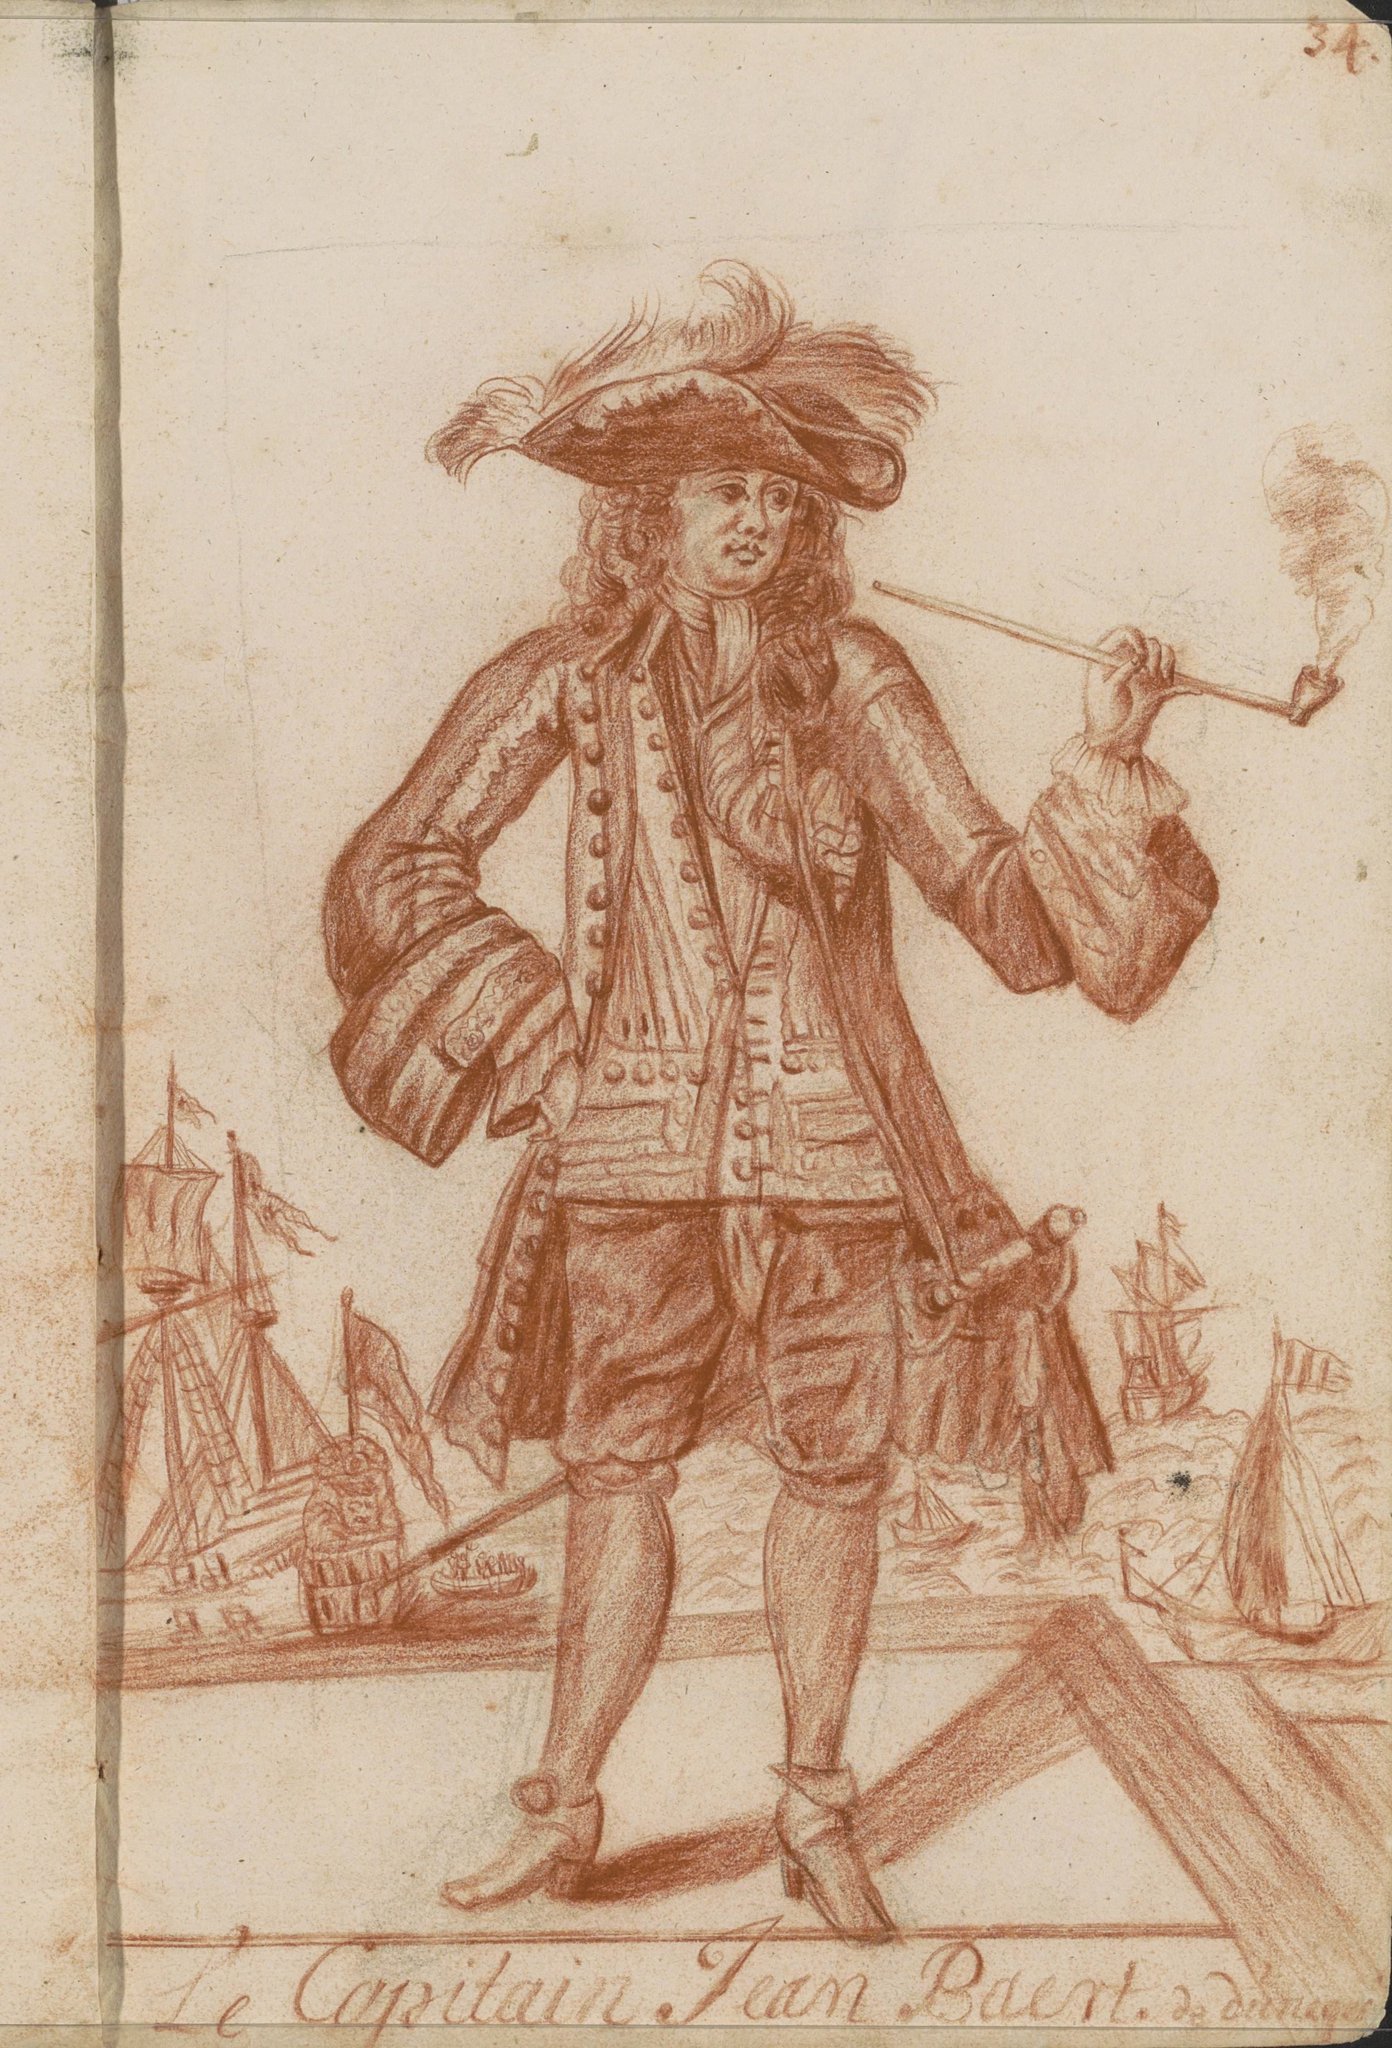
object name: sketchbook leaf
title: Portret van Jan Baert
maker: hendrick van beaumont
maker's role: draughtsman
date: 1696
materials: chalk, paper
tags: seaman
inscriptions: annotation: ‘Le Capitain Jean Baert. de duneqe[...]’, number: ‘34’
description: Baert draagt een kapiteinskostuum en rookt een pijp. Op de achtergrond zeilschepen op zee. Blad 29 recto uit een schetsboek met 30 bladen.